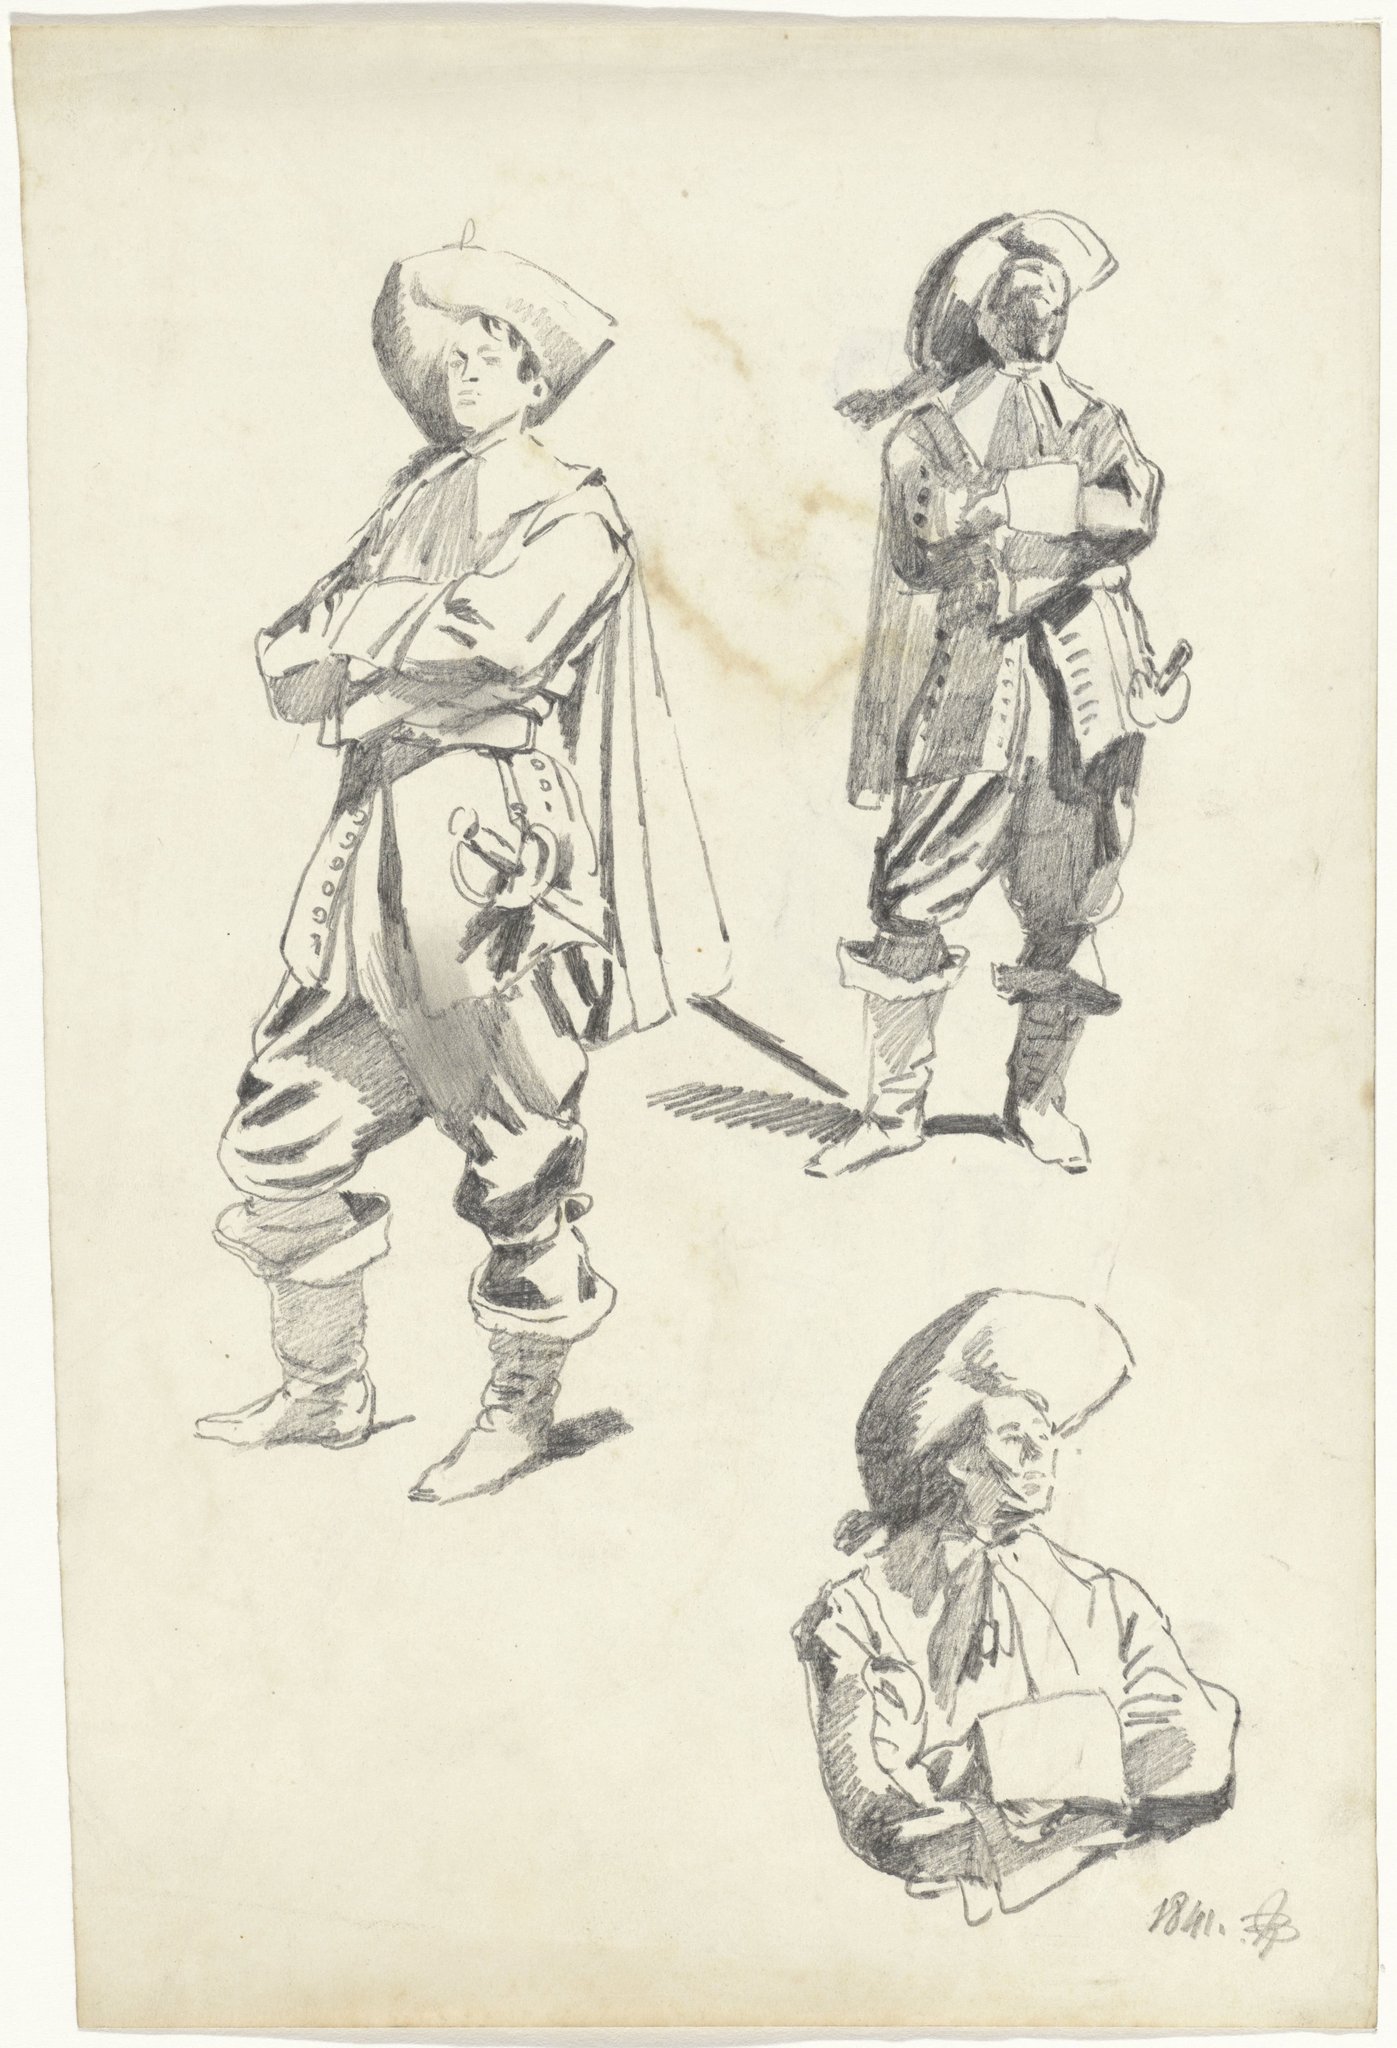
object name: drawing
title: Drie studies van een soldaat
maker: pieter van loon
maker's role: draughtsman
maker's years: 1801-1873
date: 1841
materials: paper, pencil